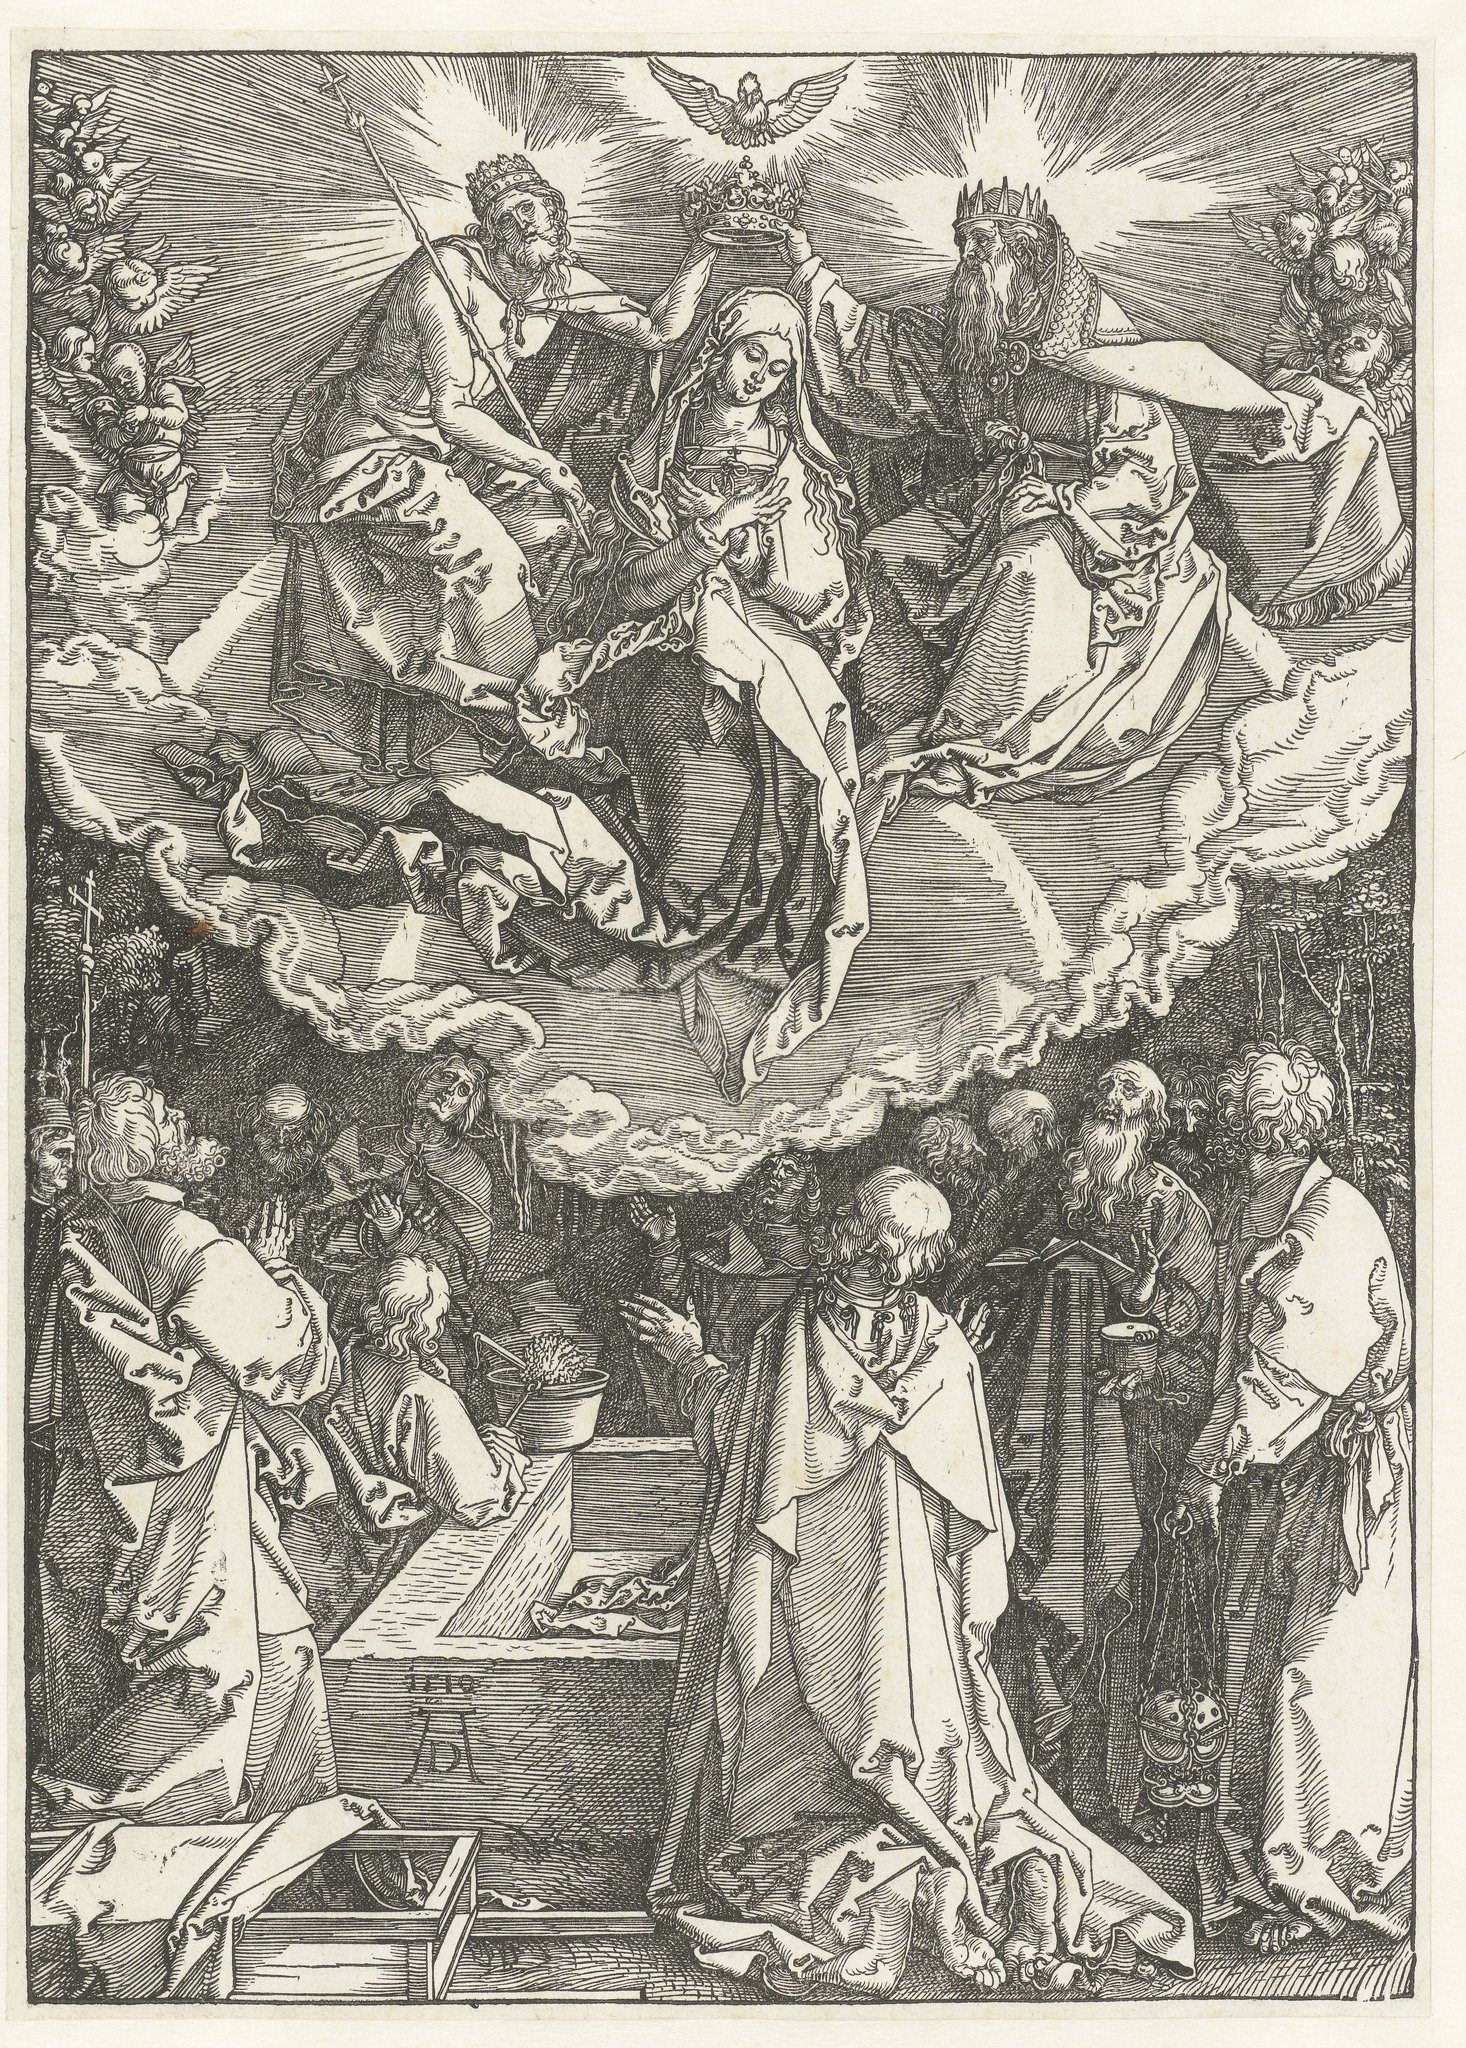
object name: print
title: Leven van Maria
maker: albrecht dürer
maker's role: draughtsman, painter, print maker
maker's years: 1471-1528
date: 1510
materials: paper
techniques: woodcut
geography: nuremberg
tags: assumption of mary combined with her coronation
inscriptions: inscription: ‘Geoffreerd aan de Teken Akademie / der stadt Amsterdam / 1788 P...’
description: De apostelen staan om een leeg graf en kijken omhoog, waar Maria in de hemel door Christus en God wordt gekroond. Deze prent is onderdeel van een serie van 20 prenten, bestaand uit een titelprent en 19 prenten met scènes uit het leven van Maria.